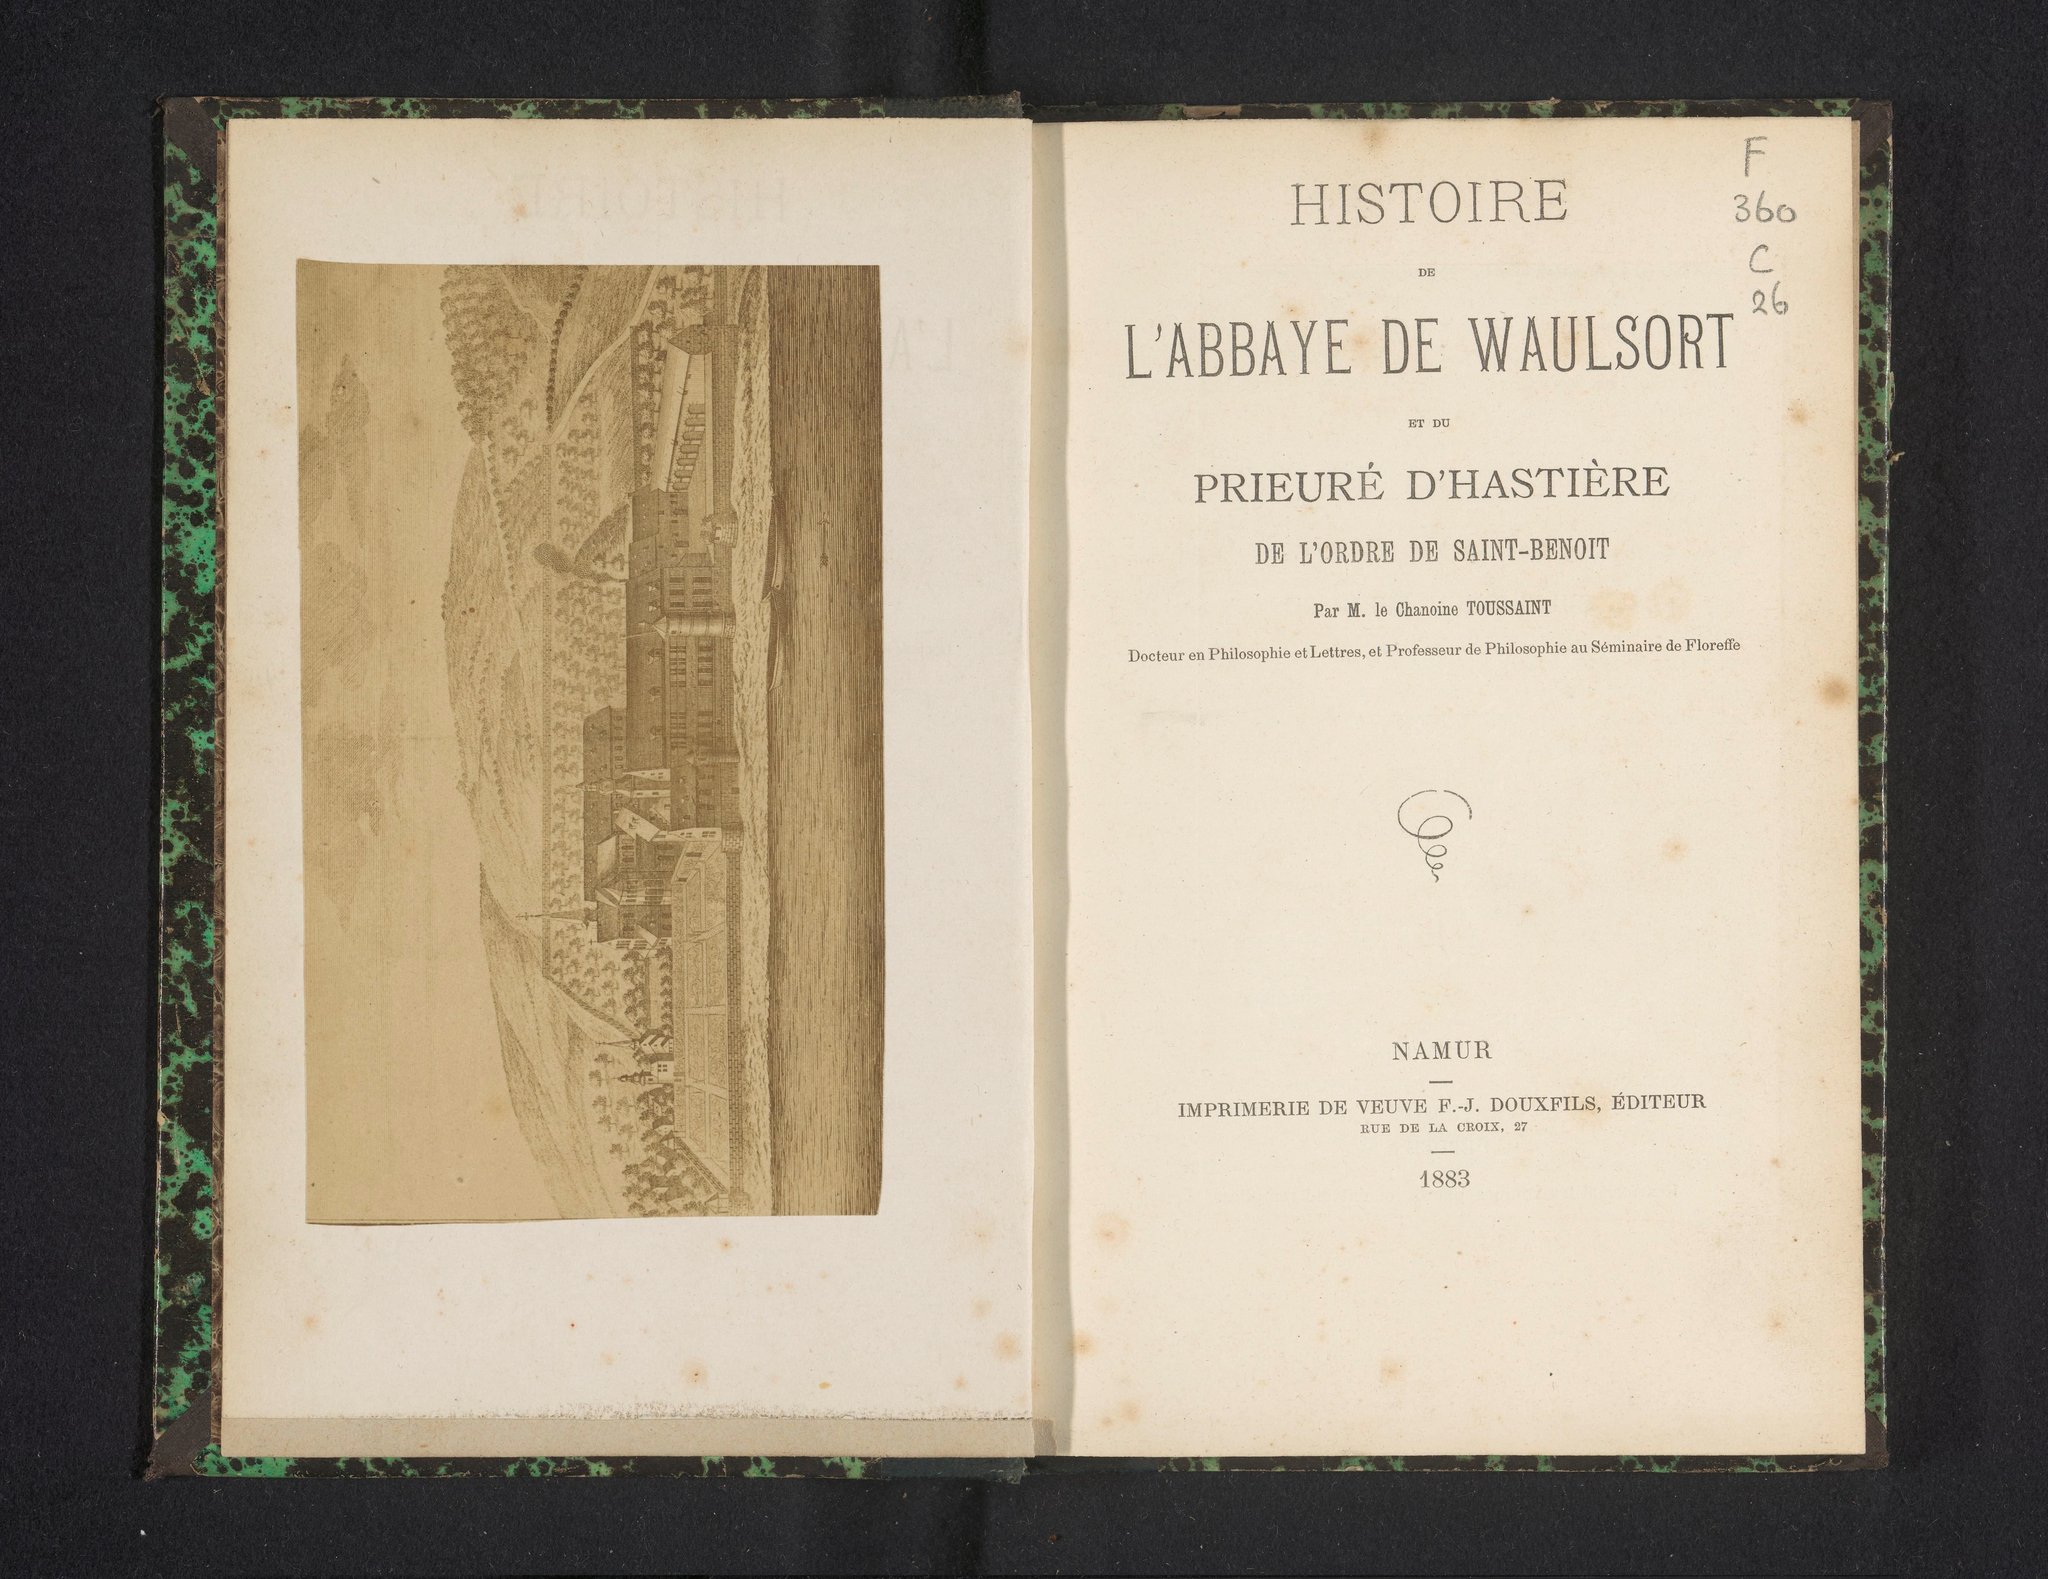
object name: photograph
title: Fotoreproductie van een ontwerp van een gezicht op de abdij van Waulsort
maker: Anonymous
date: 1878-1883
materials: photographic support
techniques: albumen print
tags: abbey, monastery, convent ~ roman catholic church